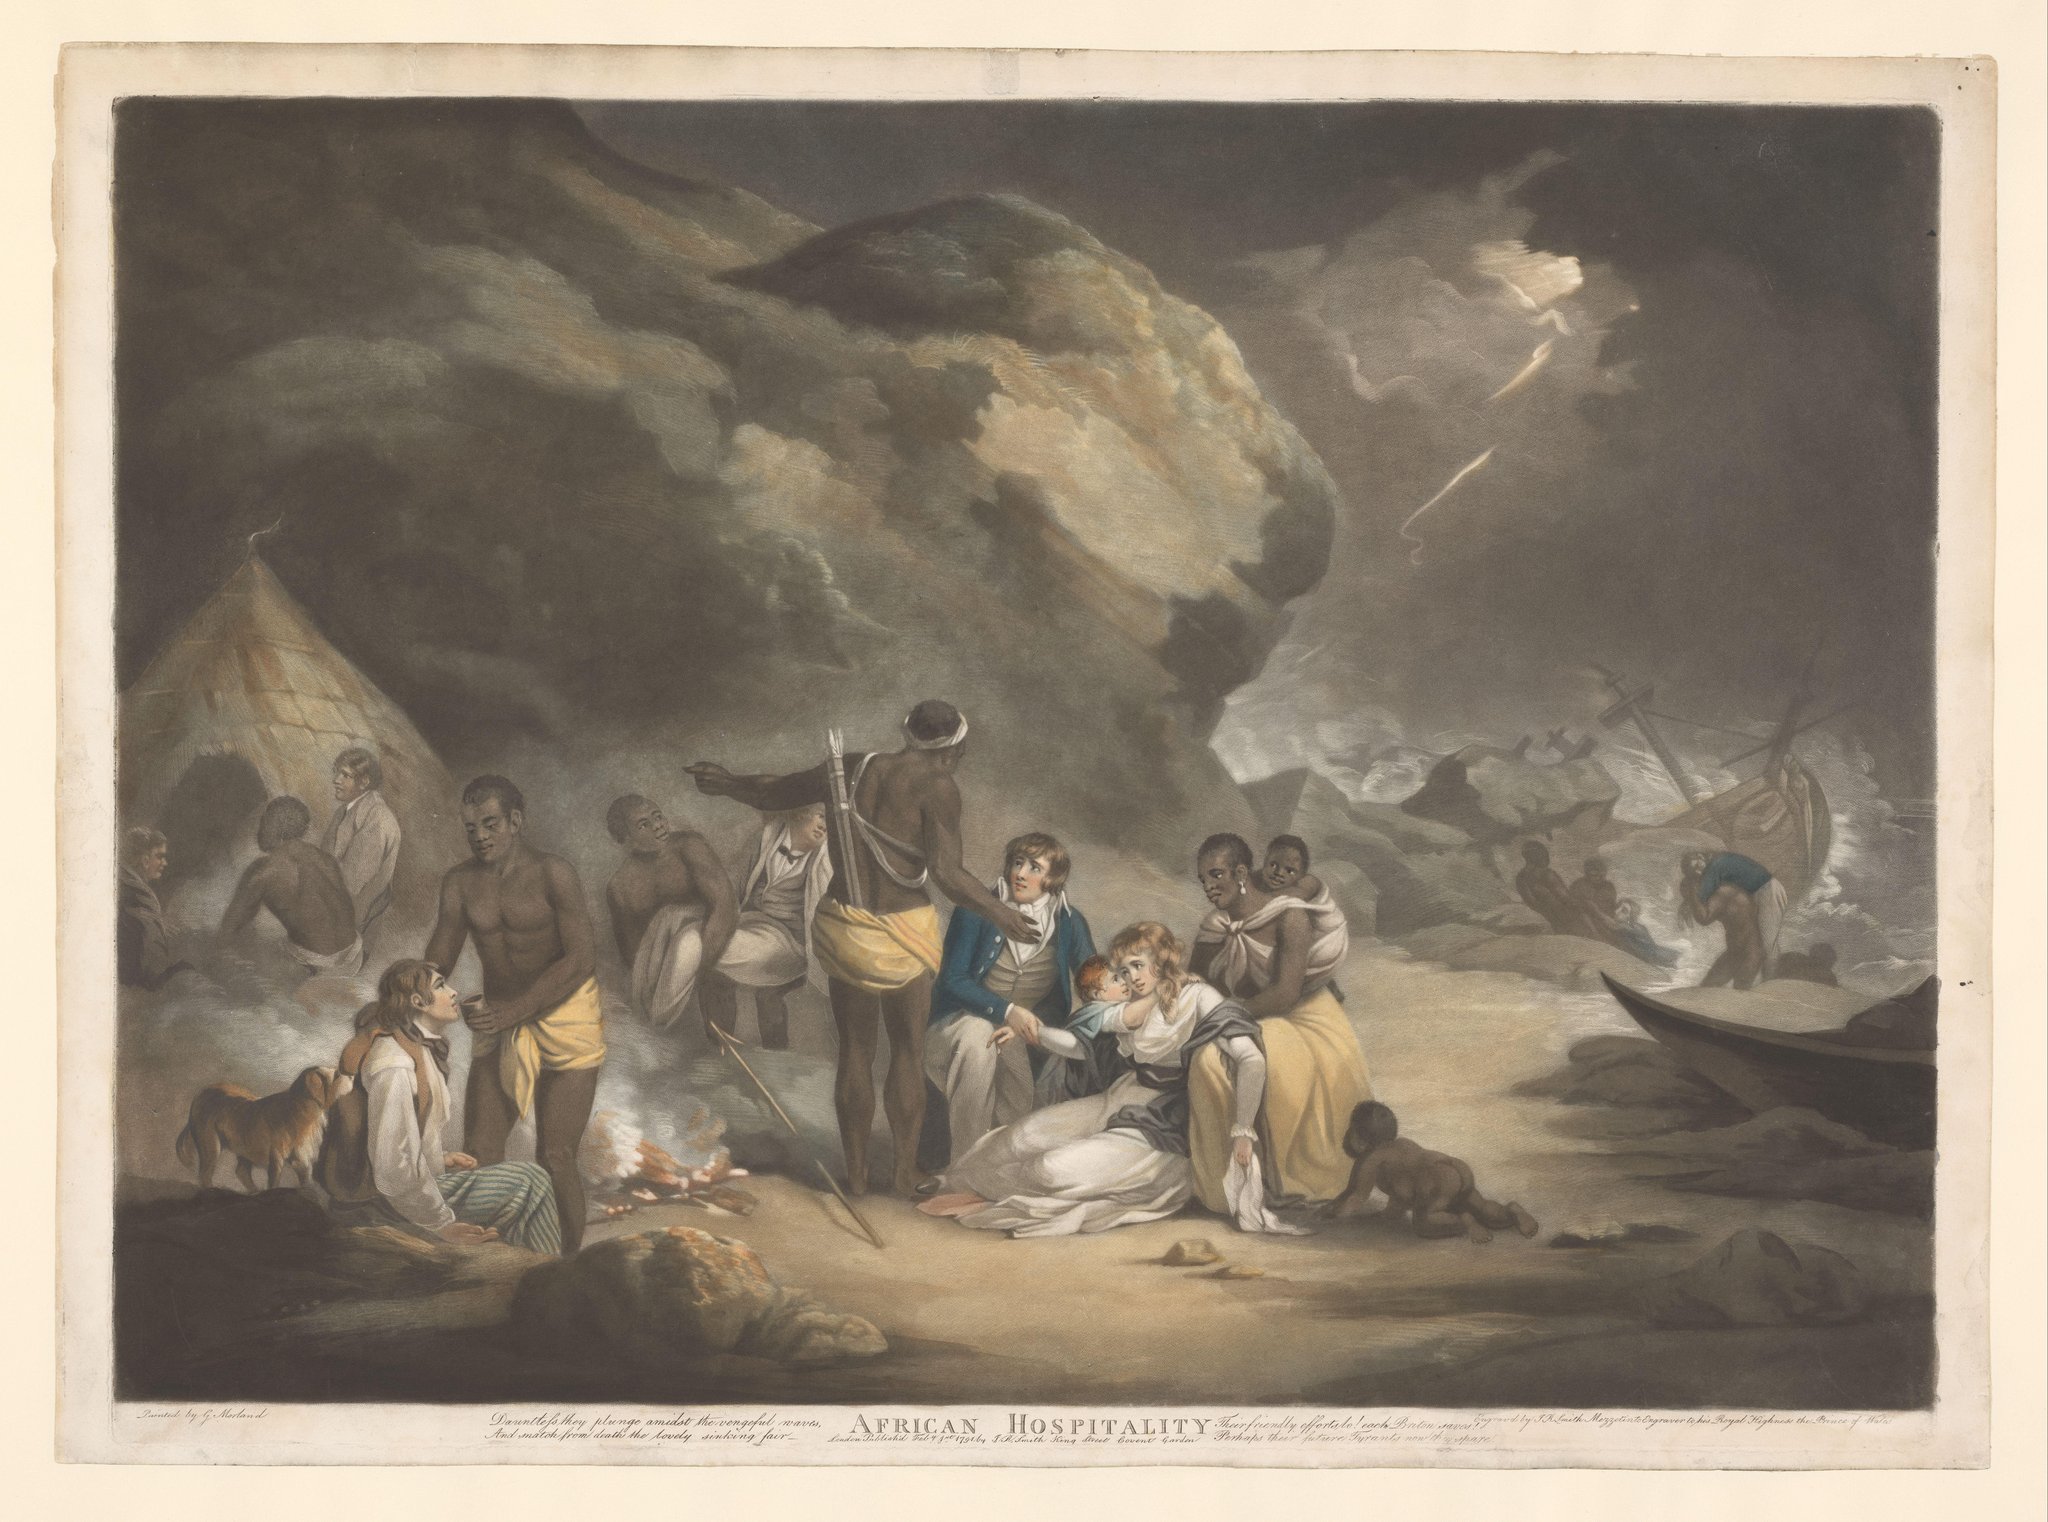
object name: print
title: Afrikaanse mensen helpen Britse schipbreukelingen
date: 1702-1791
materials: paper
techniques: etching, hand coloring, lithography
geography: london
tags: help (to an endangered fellow man), africans, drowning, shipwrecked person, shipwreck, europeans: englishmen, giving drink, storm at sea, saving a person from drowning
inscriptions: collector's mark: Lugt 2228